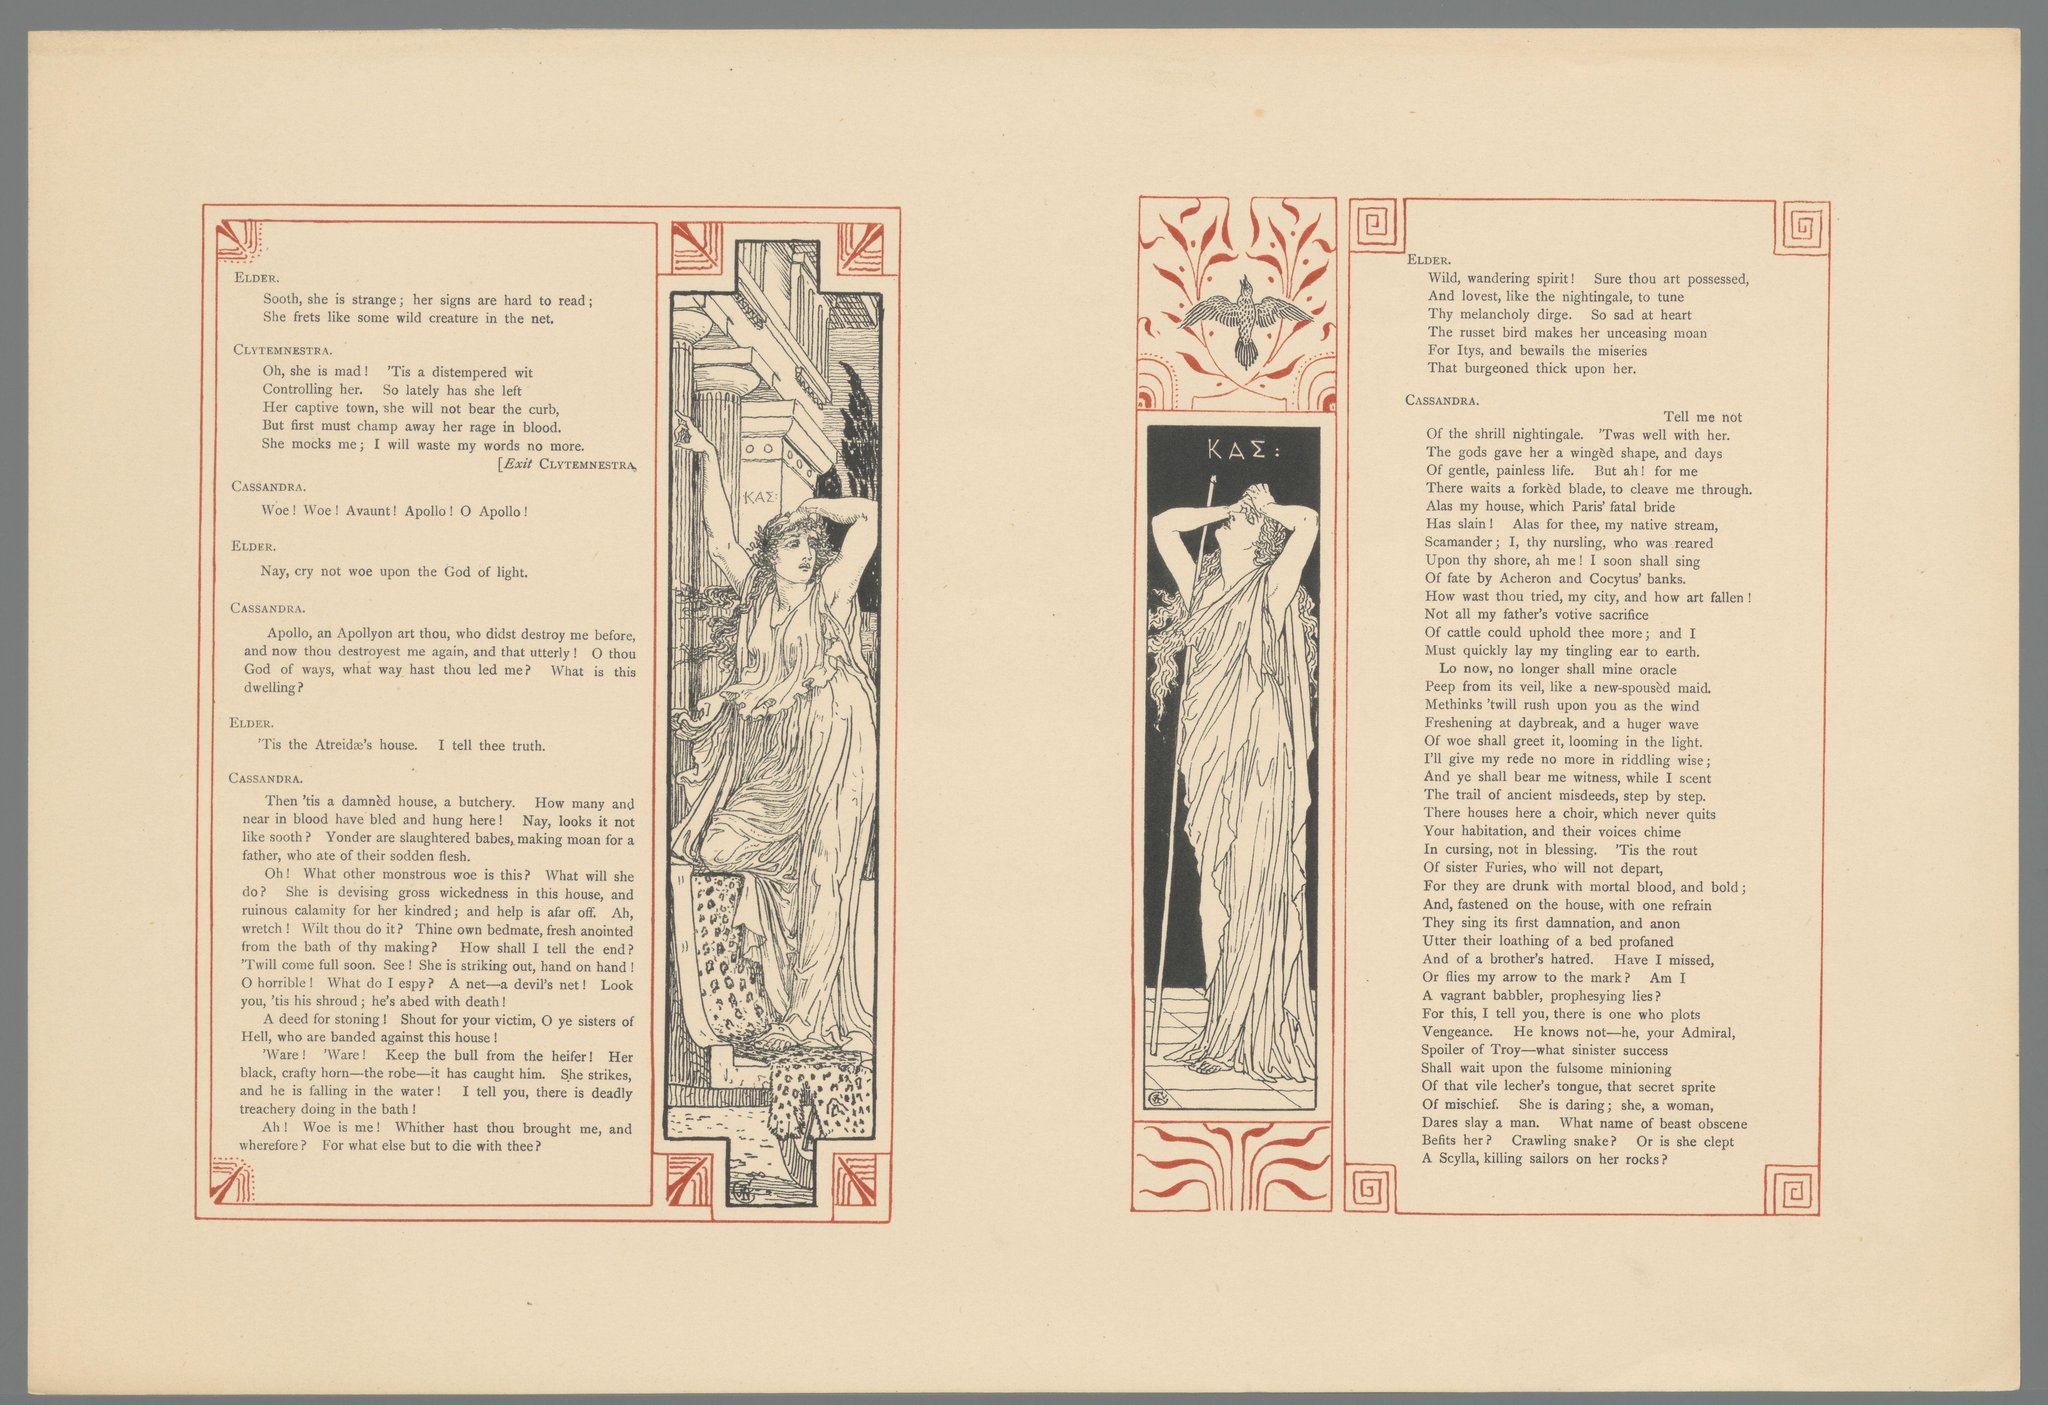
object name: book illustration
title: Twee voorstellingen van Cassandra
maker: walter crane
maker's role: draughtsman, print maker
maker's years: 1845-1915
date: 1887-1888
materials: paper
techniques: letterpress printing, lithograph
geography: london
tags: (story of) cassandra, birds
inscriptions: collector's mark: Lugt 2228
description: Prent uit: Warr, George C. Echoes of Hellas: the tale of Troy & the story of Orestes from Homer & Aeschylus. Londen: Marcus Ward & Company, [1887/1888].